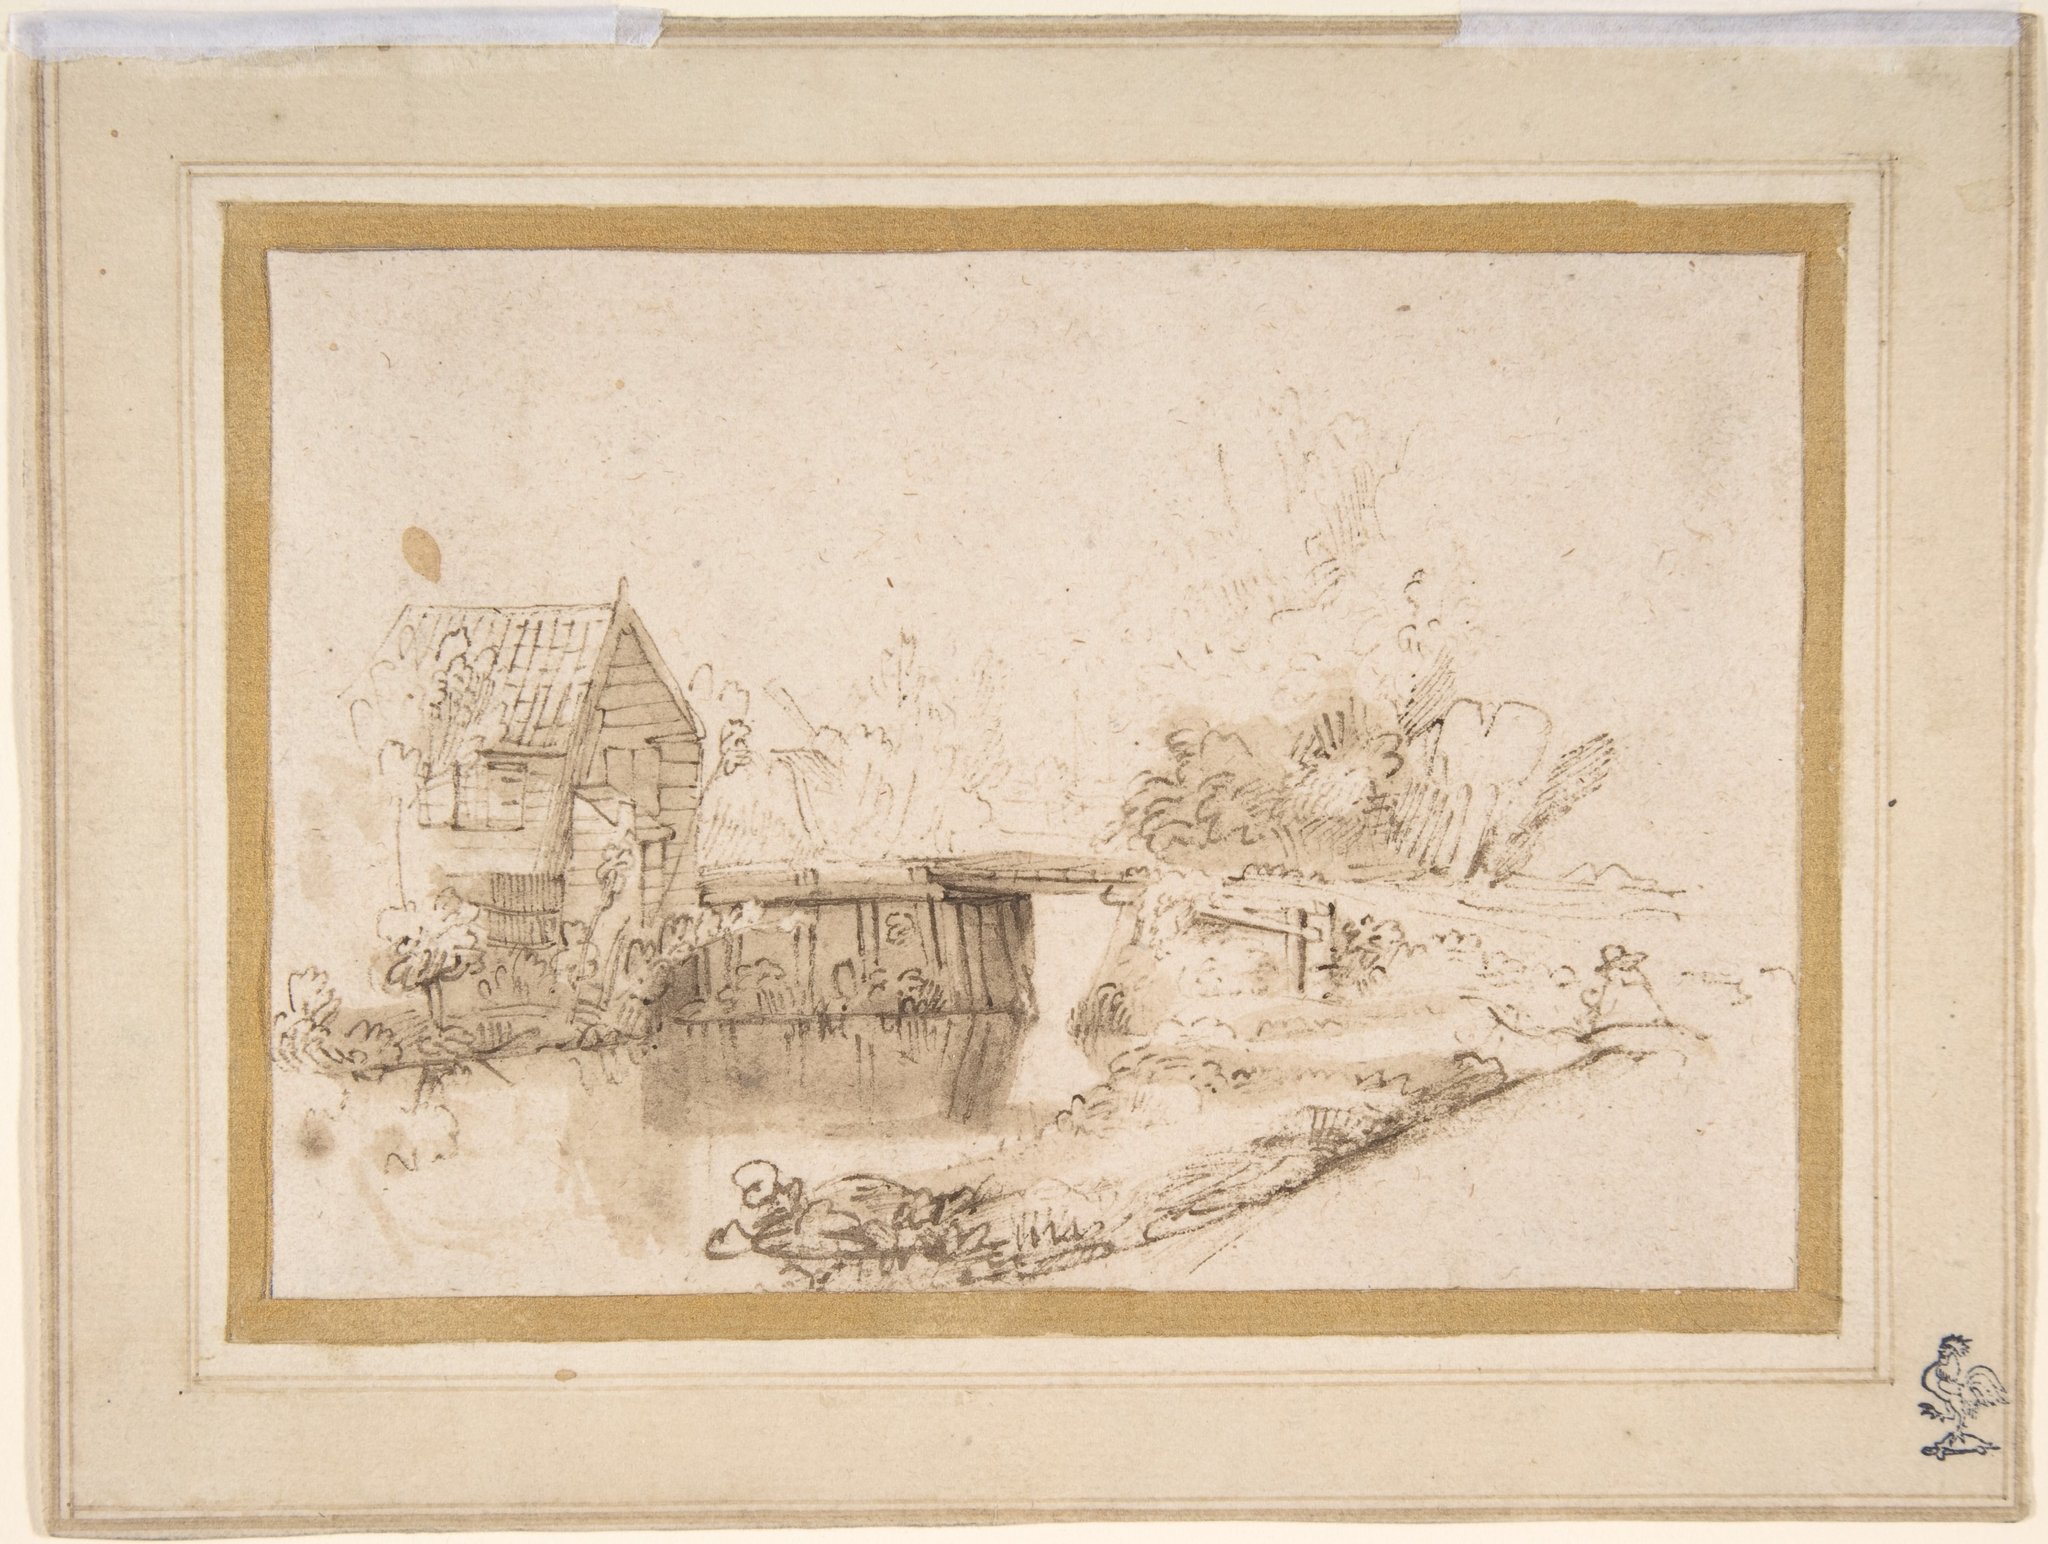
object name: drawing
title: Landscape with a Draughtsman Seated by a River, a Bridge and a Cottage Behind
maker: nicolaes maes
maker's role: artist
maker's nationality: dutch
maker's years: 1634-1693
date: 1601-1700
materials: ink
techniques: pen, wash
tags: houses,bridges,rivers,landscapes